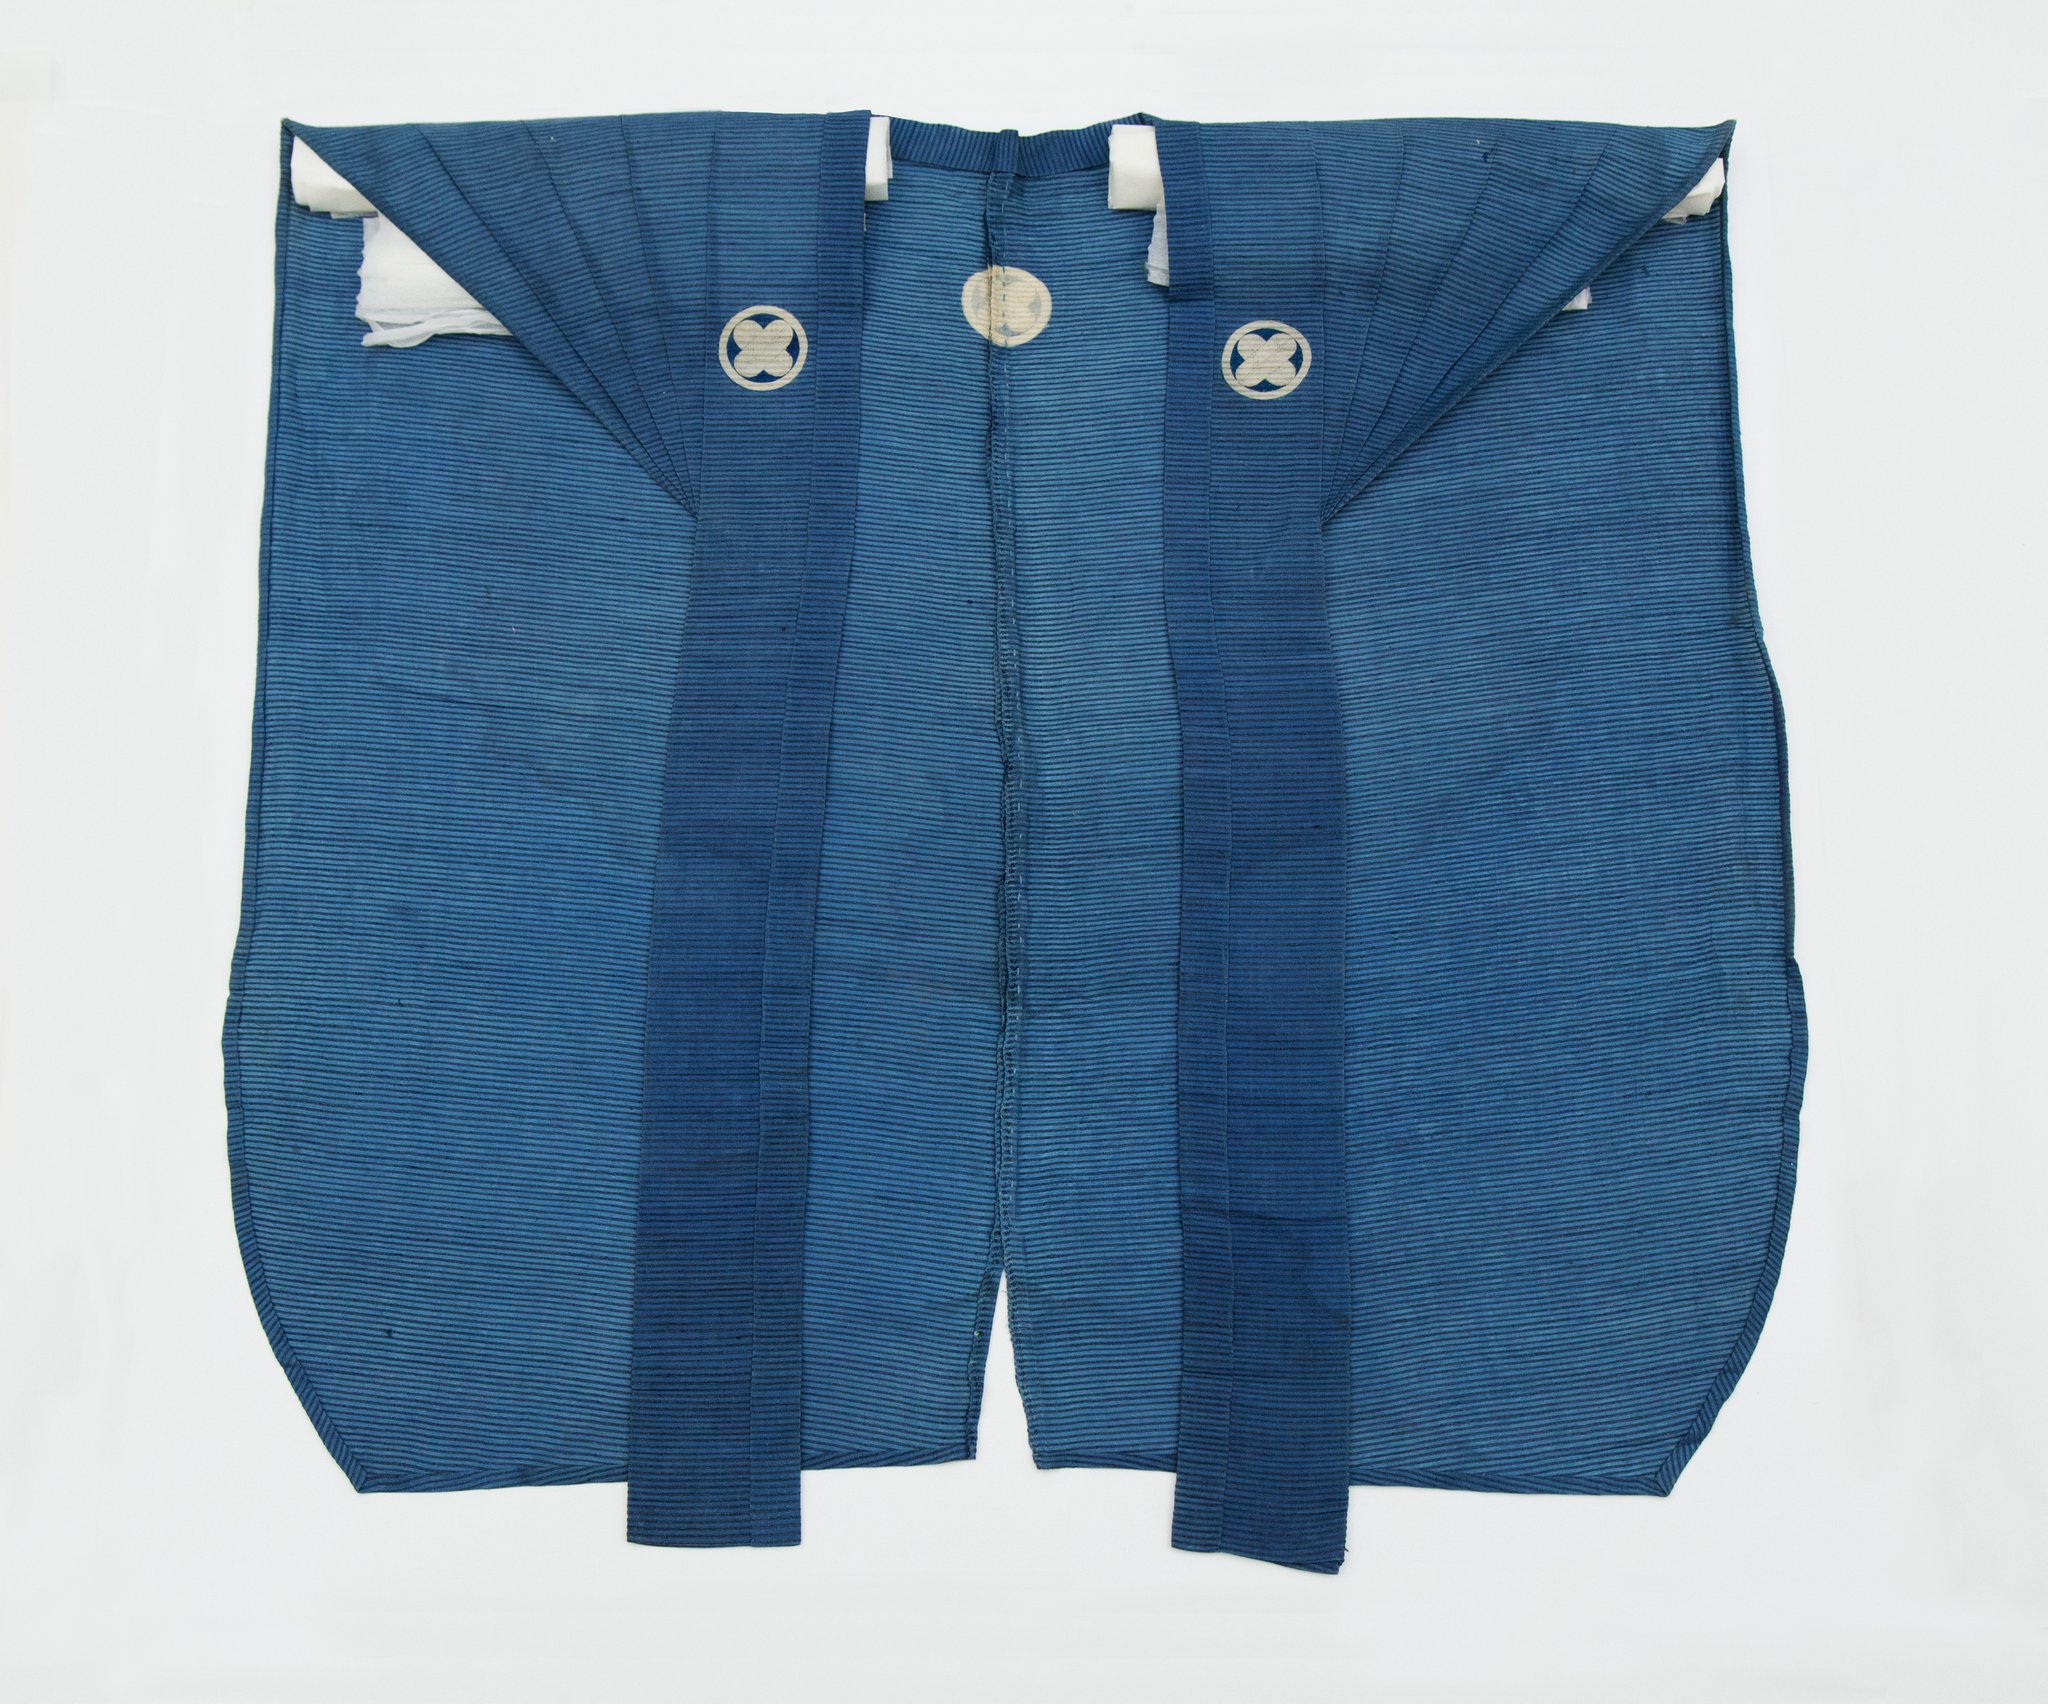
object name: overvest kataginu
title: Overvest (kataginu)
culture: japanese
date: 1615-1868